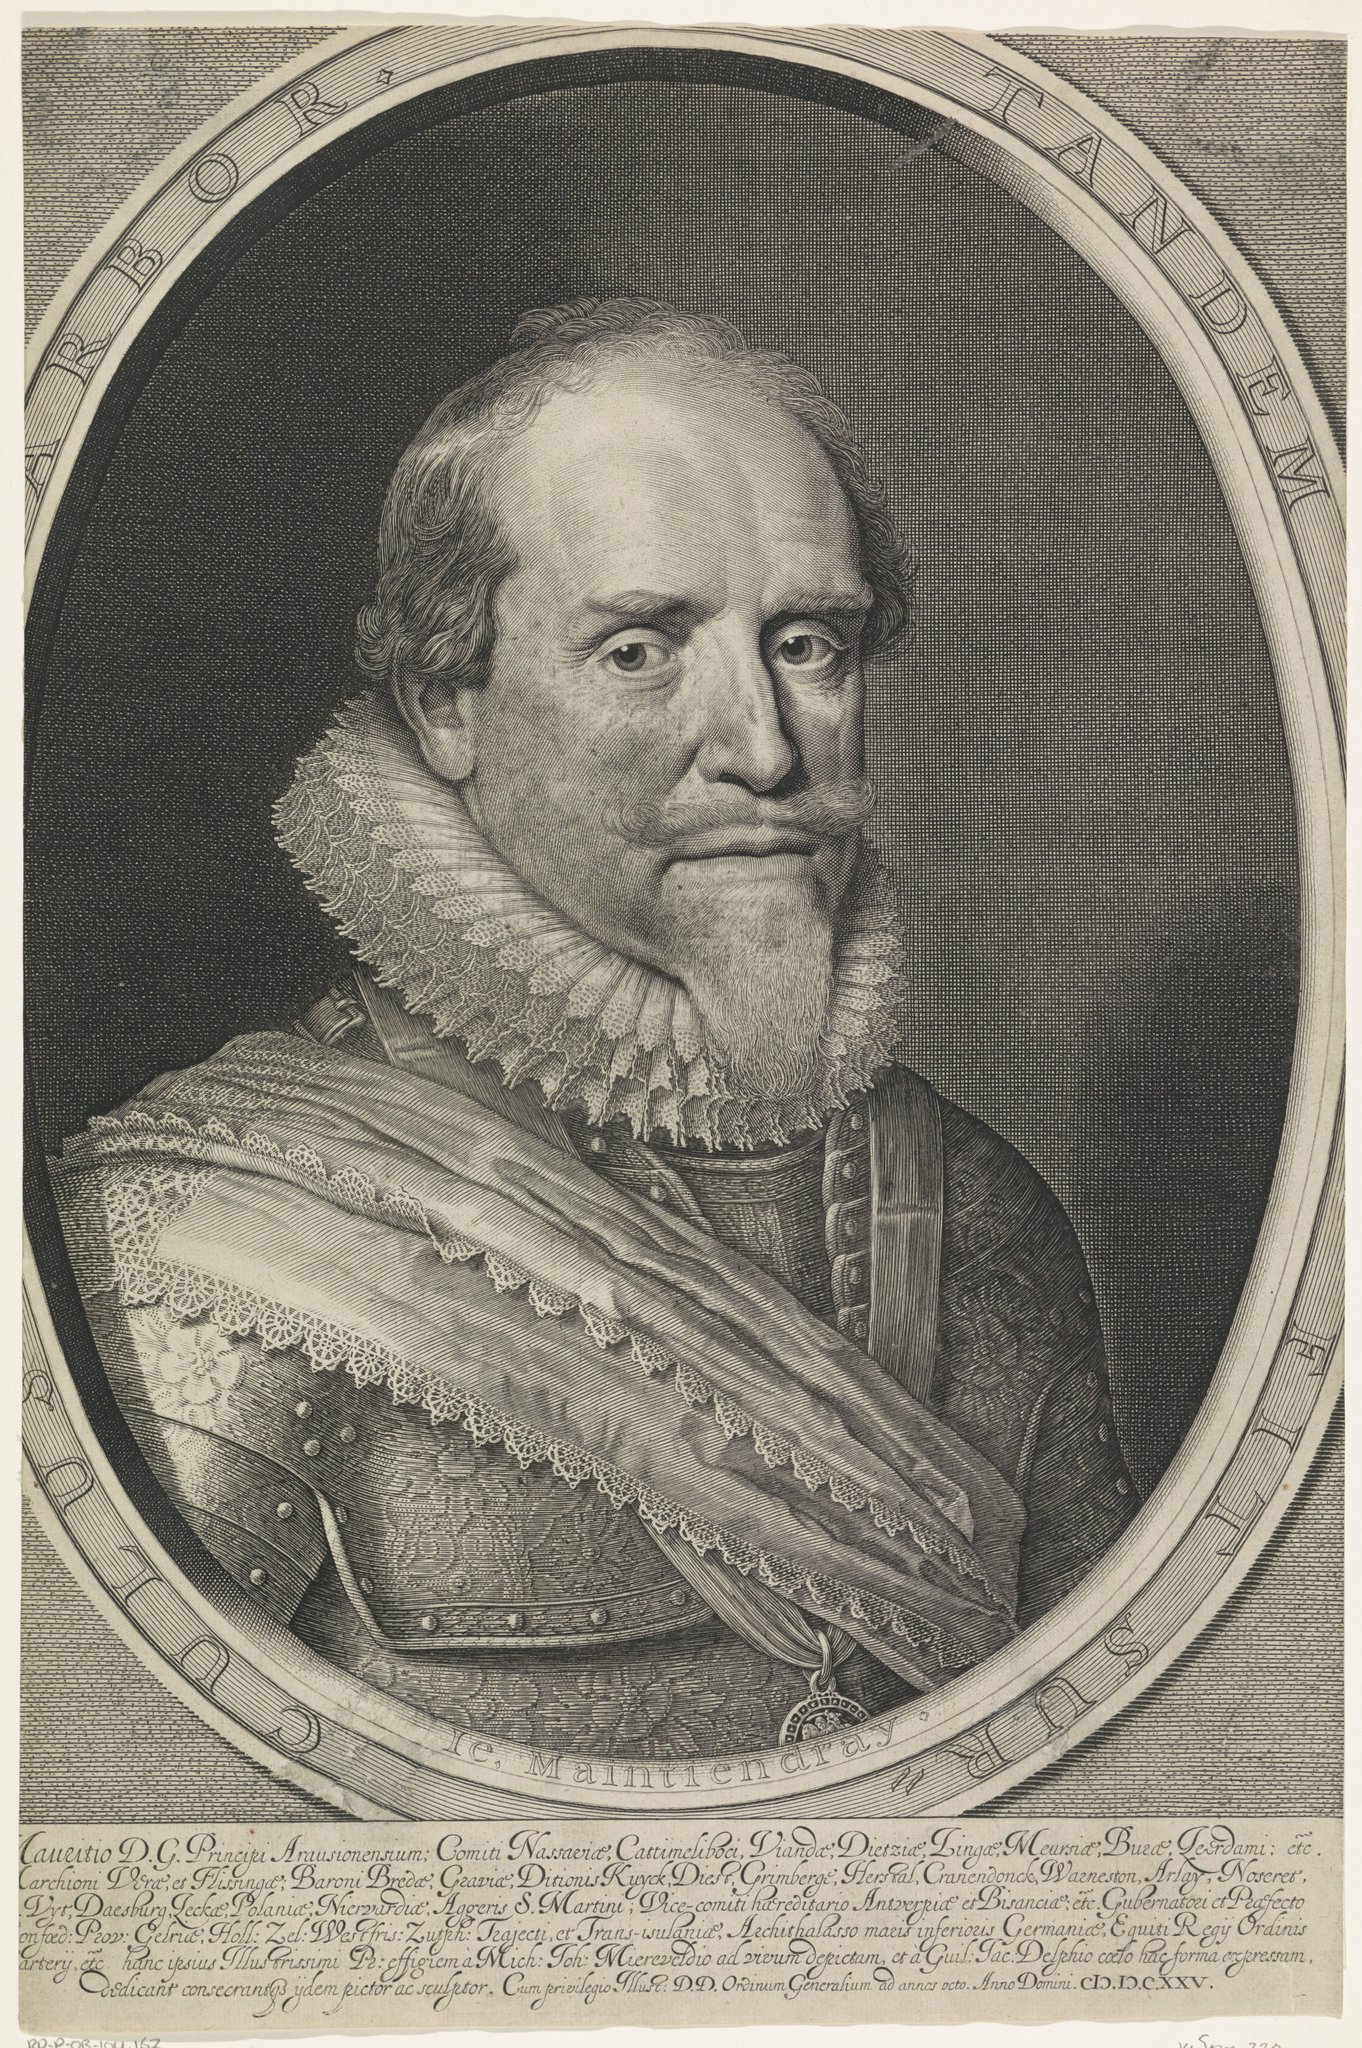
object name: print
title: Portret van Maurits, prins van Oranje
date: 1625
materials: paper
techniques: engraving, etching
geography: delft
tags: the hague, maurice (prince of orange), knighthood order (garter) - insignia of a knighthood order, e.g.: badge, chain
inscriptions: date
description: De hier vermelde titel verwijst naar de hoogst verkregen titel van de geportretteerde, niet per se naar de titel die de geportretteerde op deze voorstelling draagt.